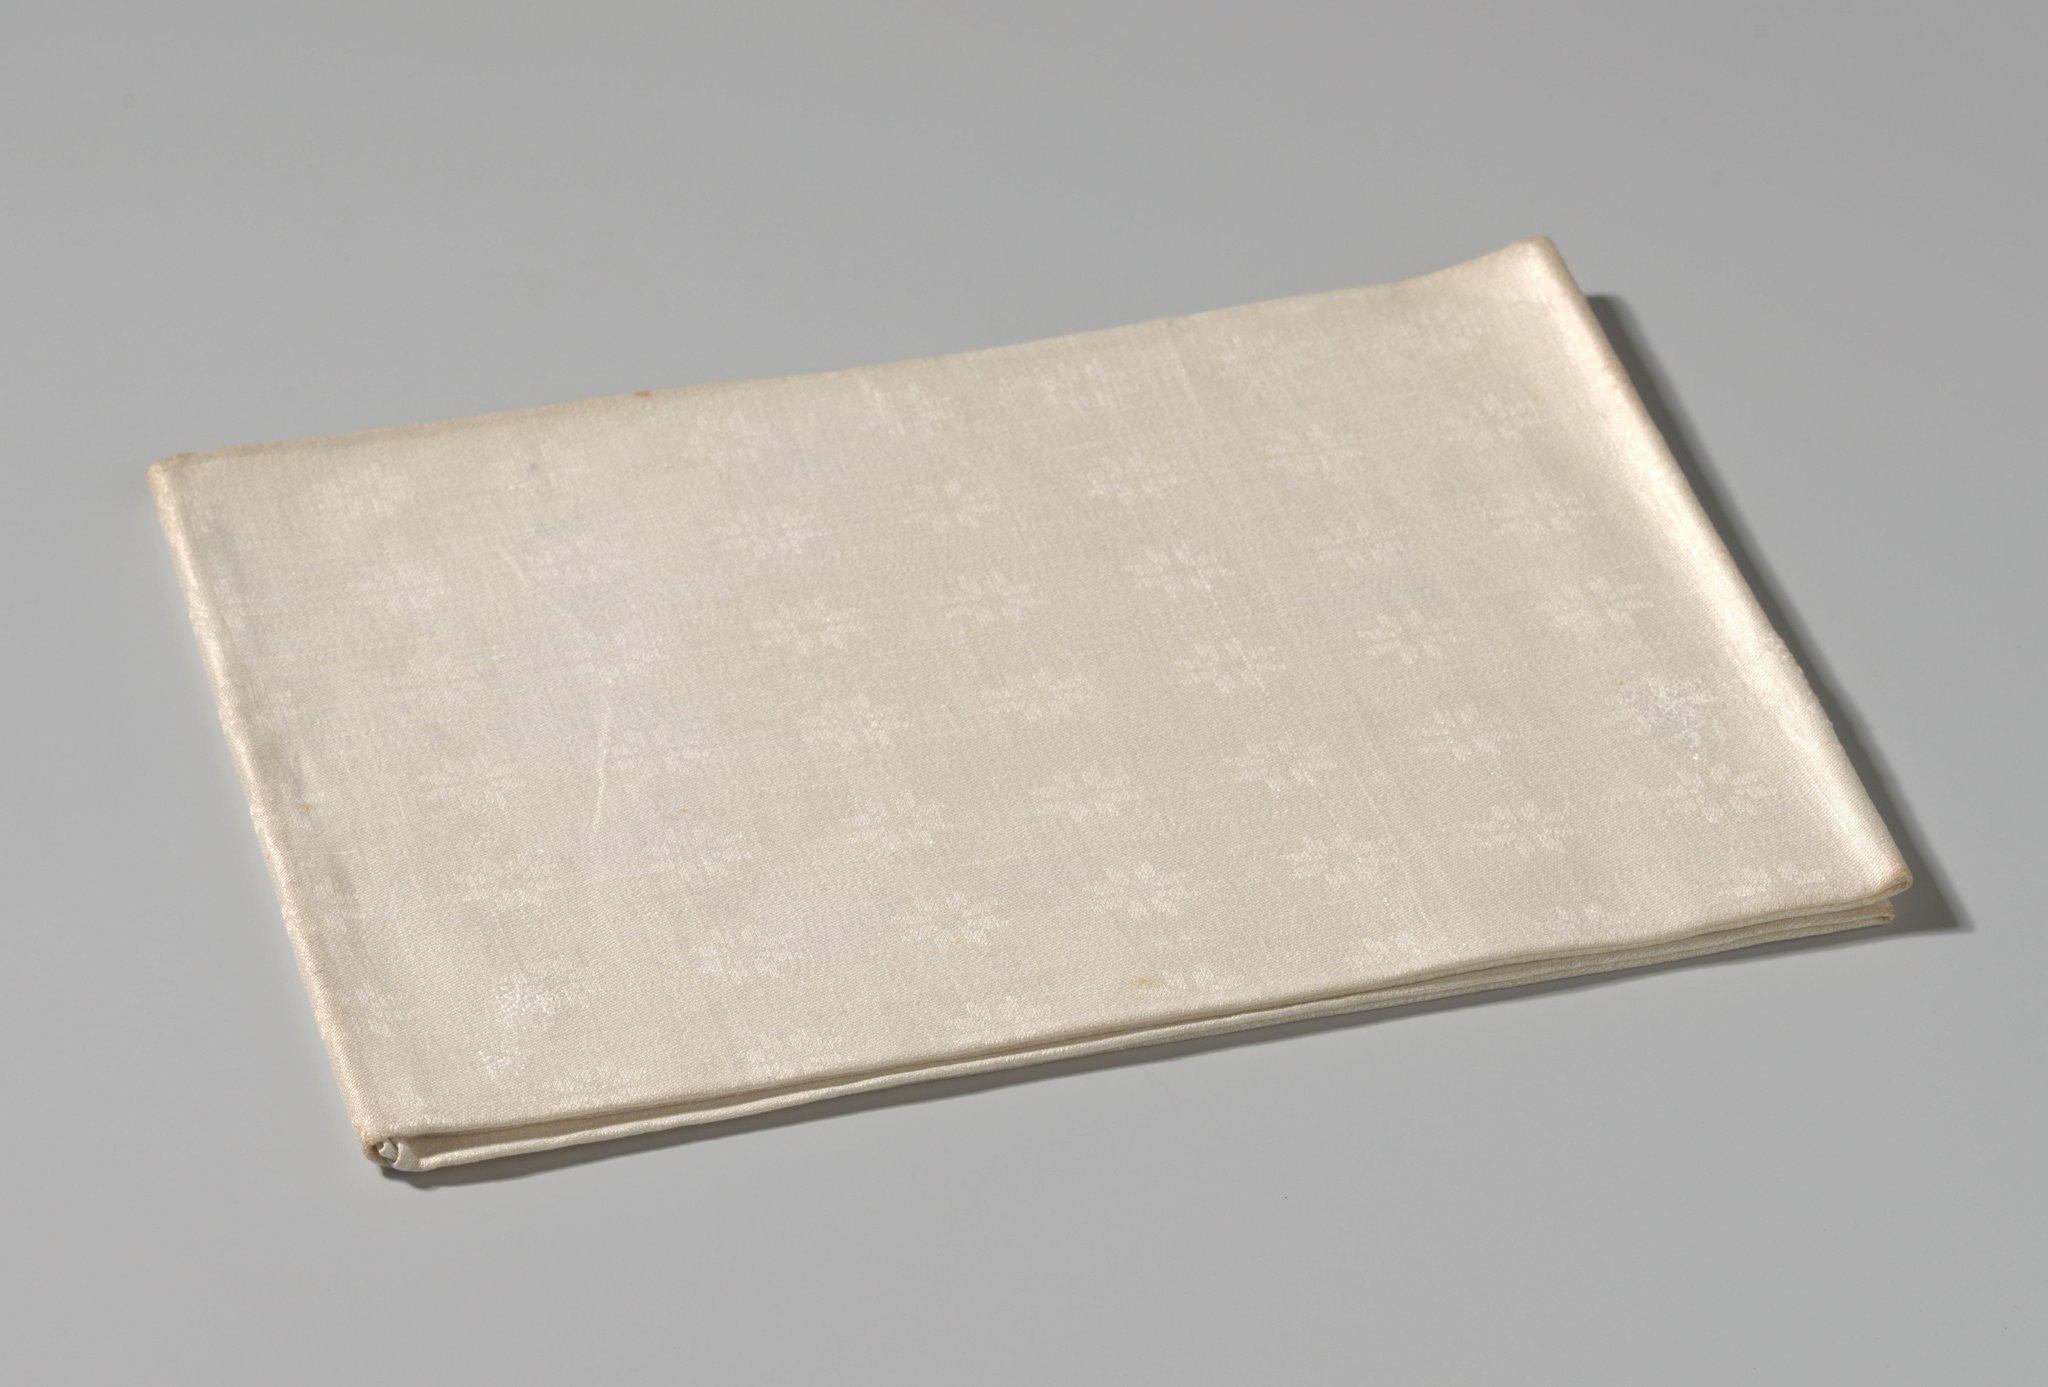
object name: napkin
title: Servet van linnen met pellenpatroon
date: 1825-1875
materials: linen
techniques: peeled fabric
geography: northern netherlands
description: wit linnen servet met een pellen patroon van sterren